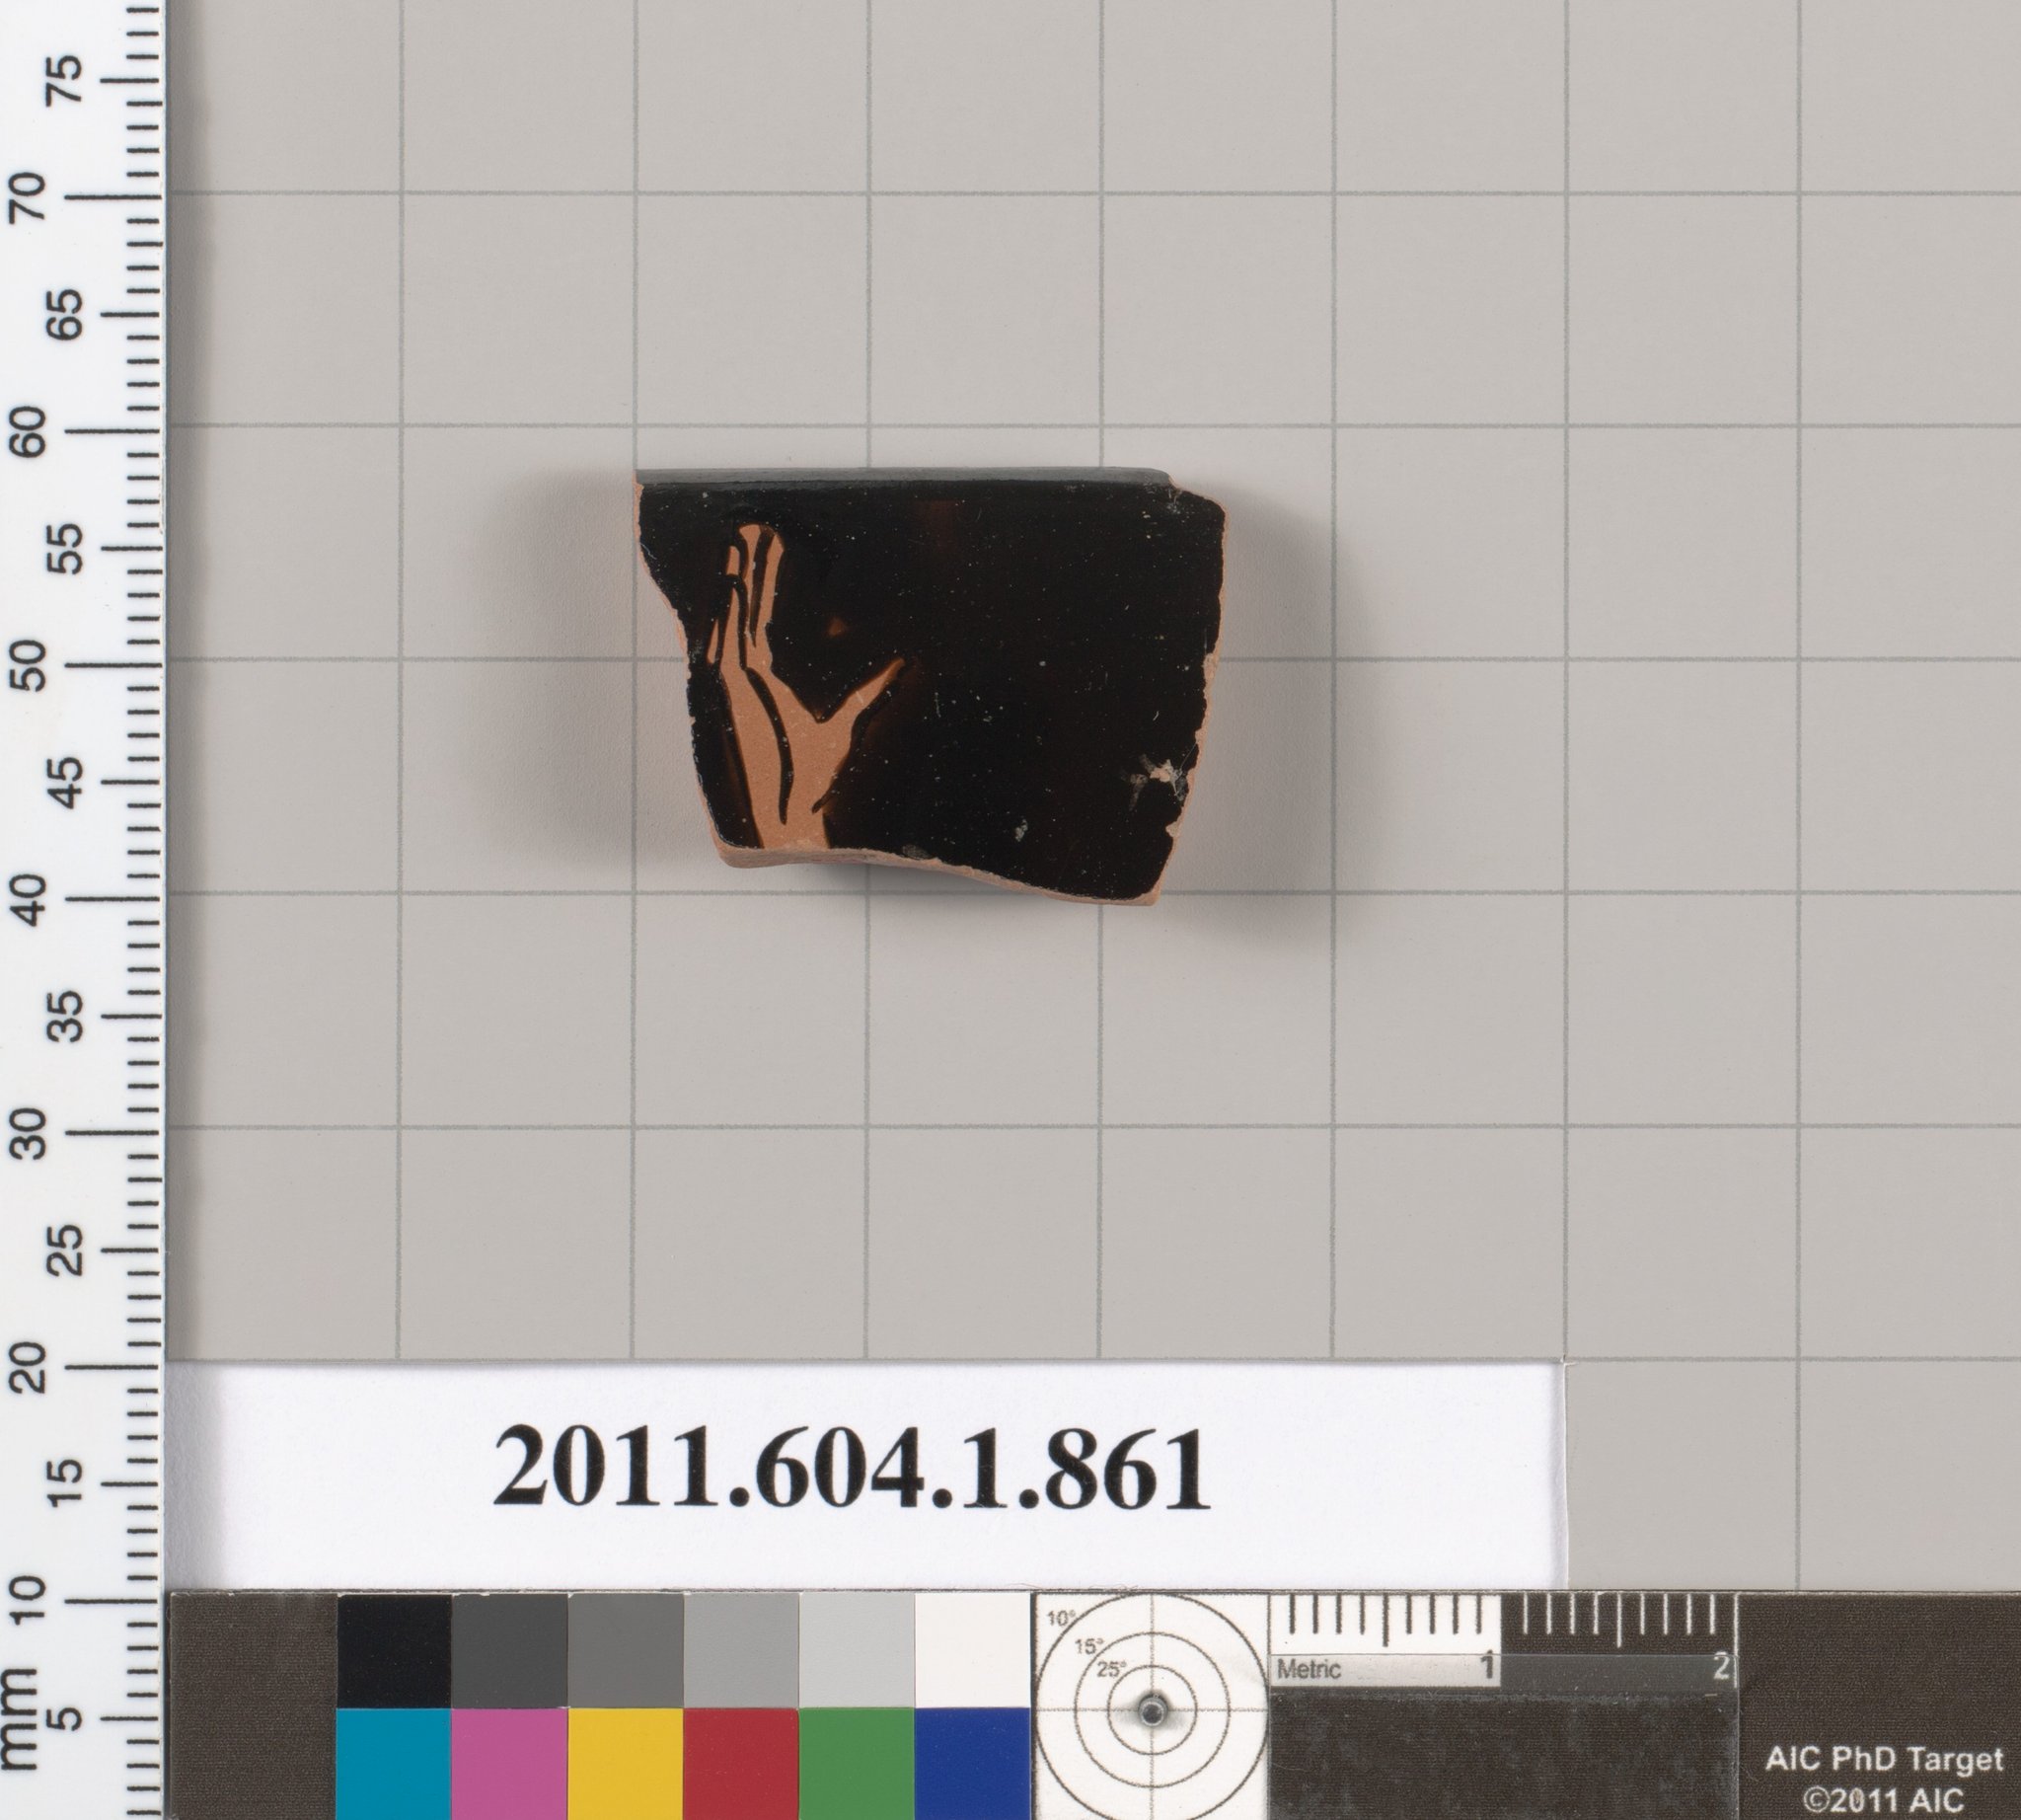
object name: kylix fragment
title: Terracotta rim fragment of a kylix (drinking cup)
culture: greek, attic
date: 475-451 BCE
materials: terracotta